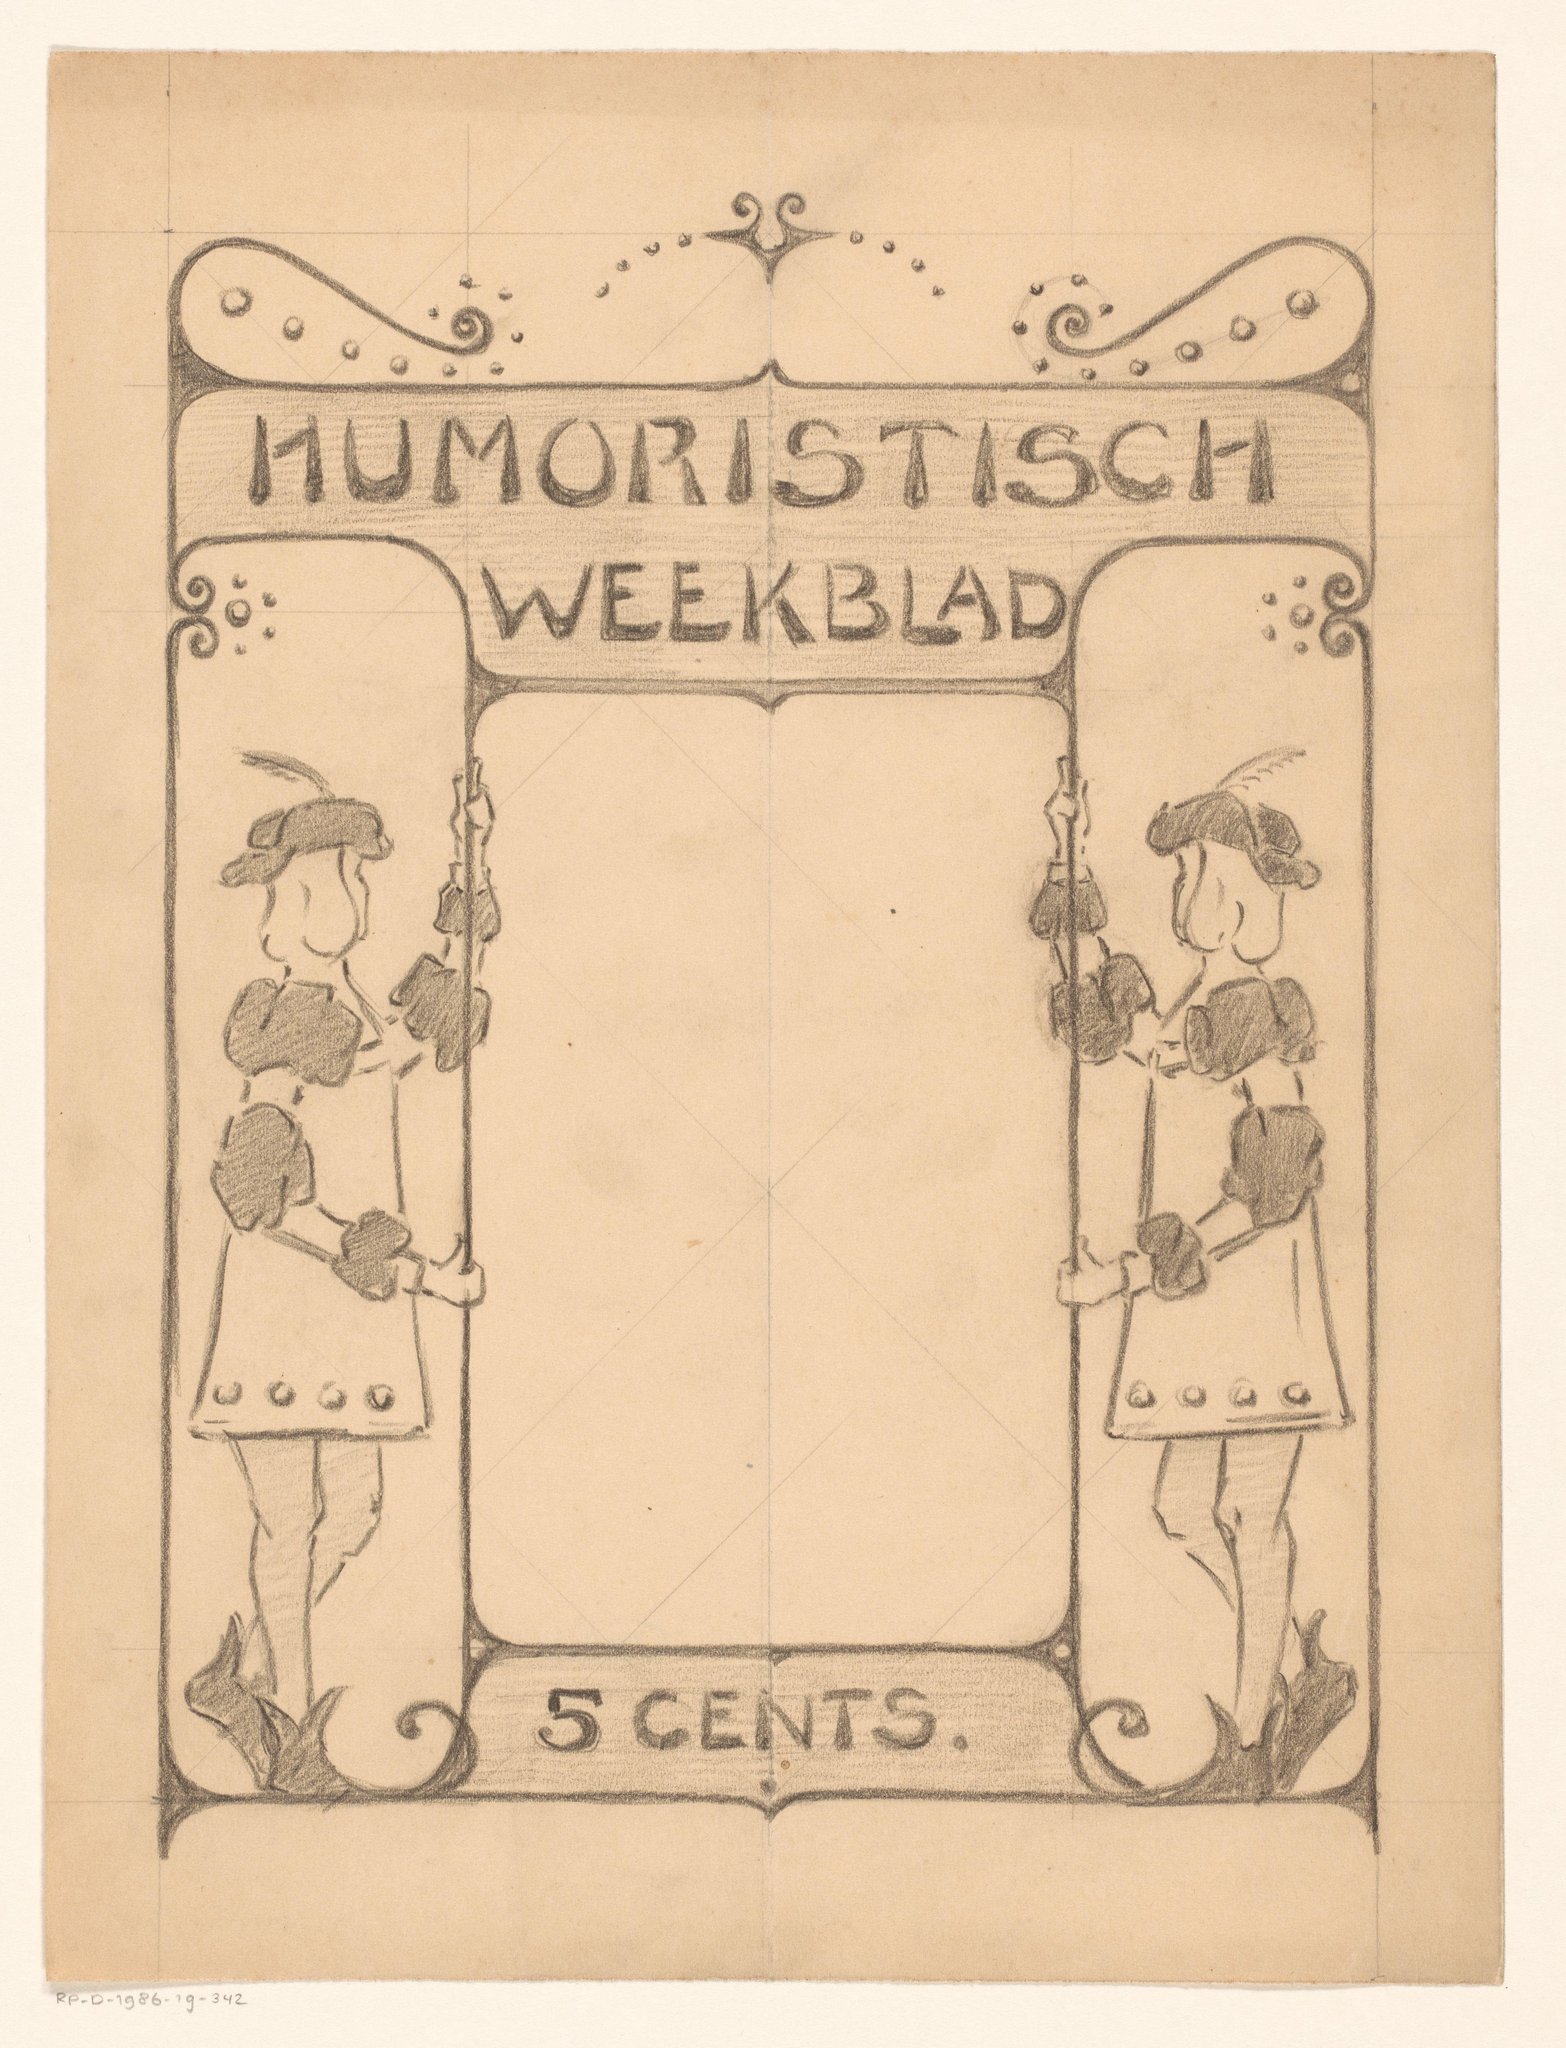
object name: drawing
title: Omslagontwerp voor: Humoristisch weekblad, c. 1906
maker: reinier willem petrus de vries (1874-1953)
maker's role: draughtsman, print maker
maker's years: 1874-1953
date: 1906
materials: paper, pencil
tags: standing figure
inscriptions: collector's mark: ‘R:MVS.’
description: Rechthoekig kader met bovenaan de titel van het tijdschrift. Links en rechts staande mannen met schoenen met opgekrulde punten, mogelijk narren.